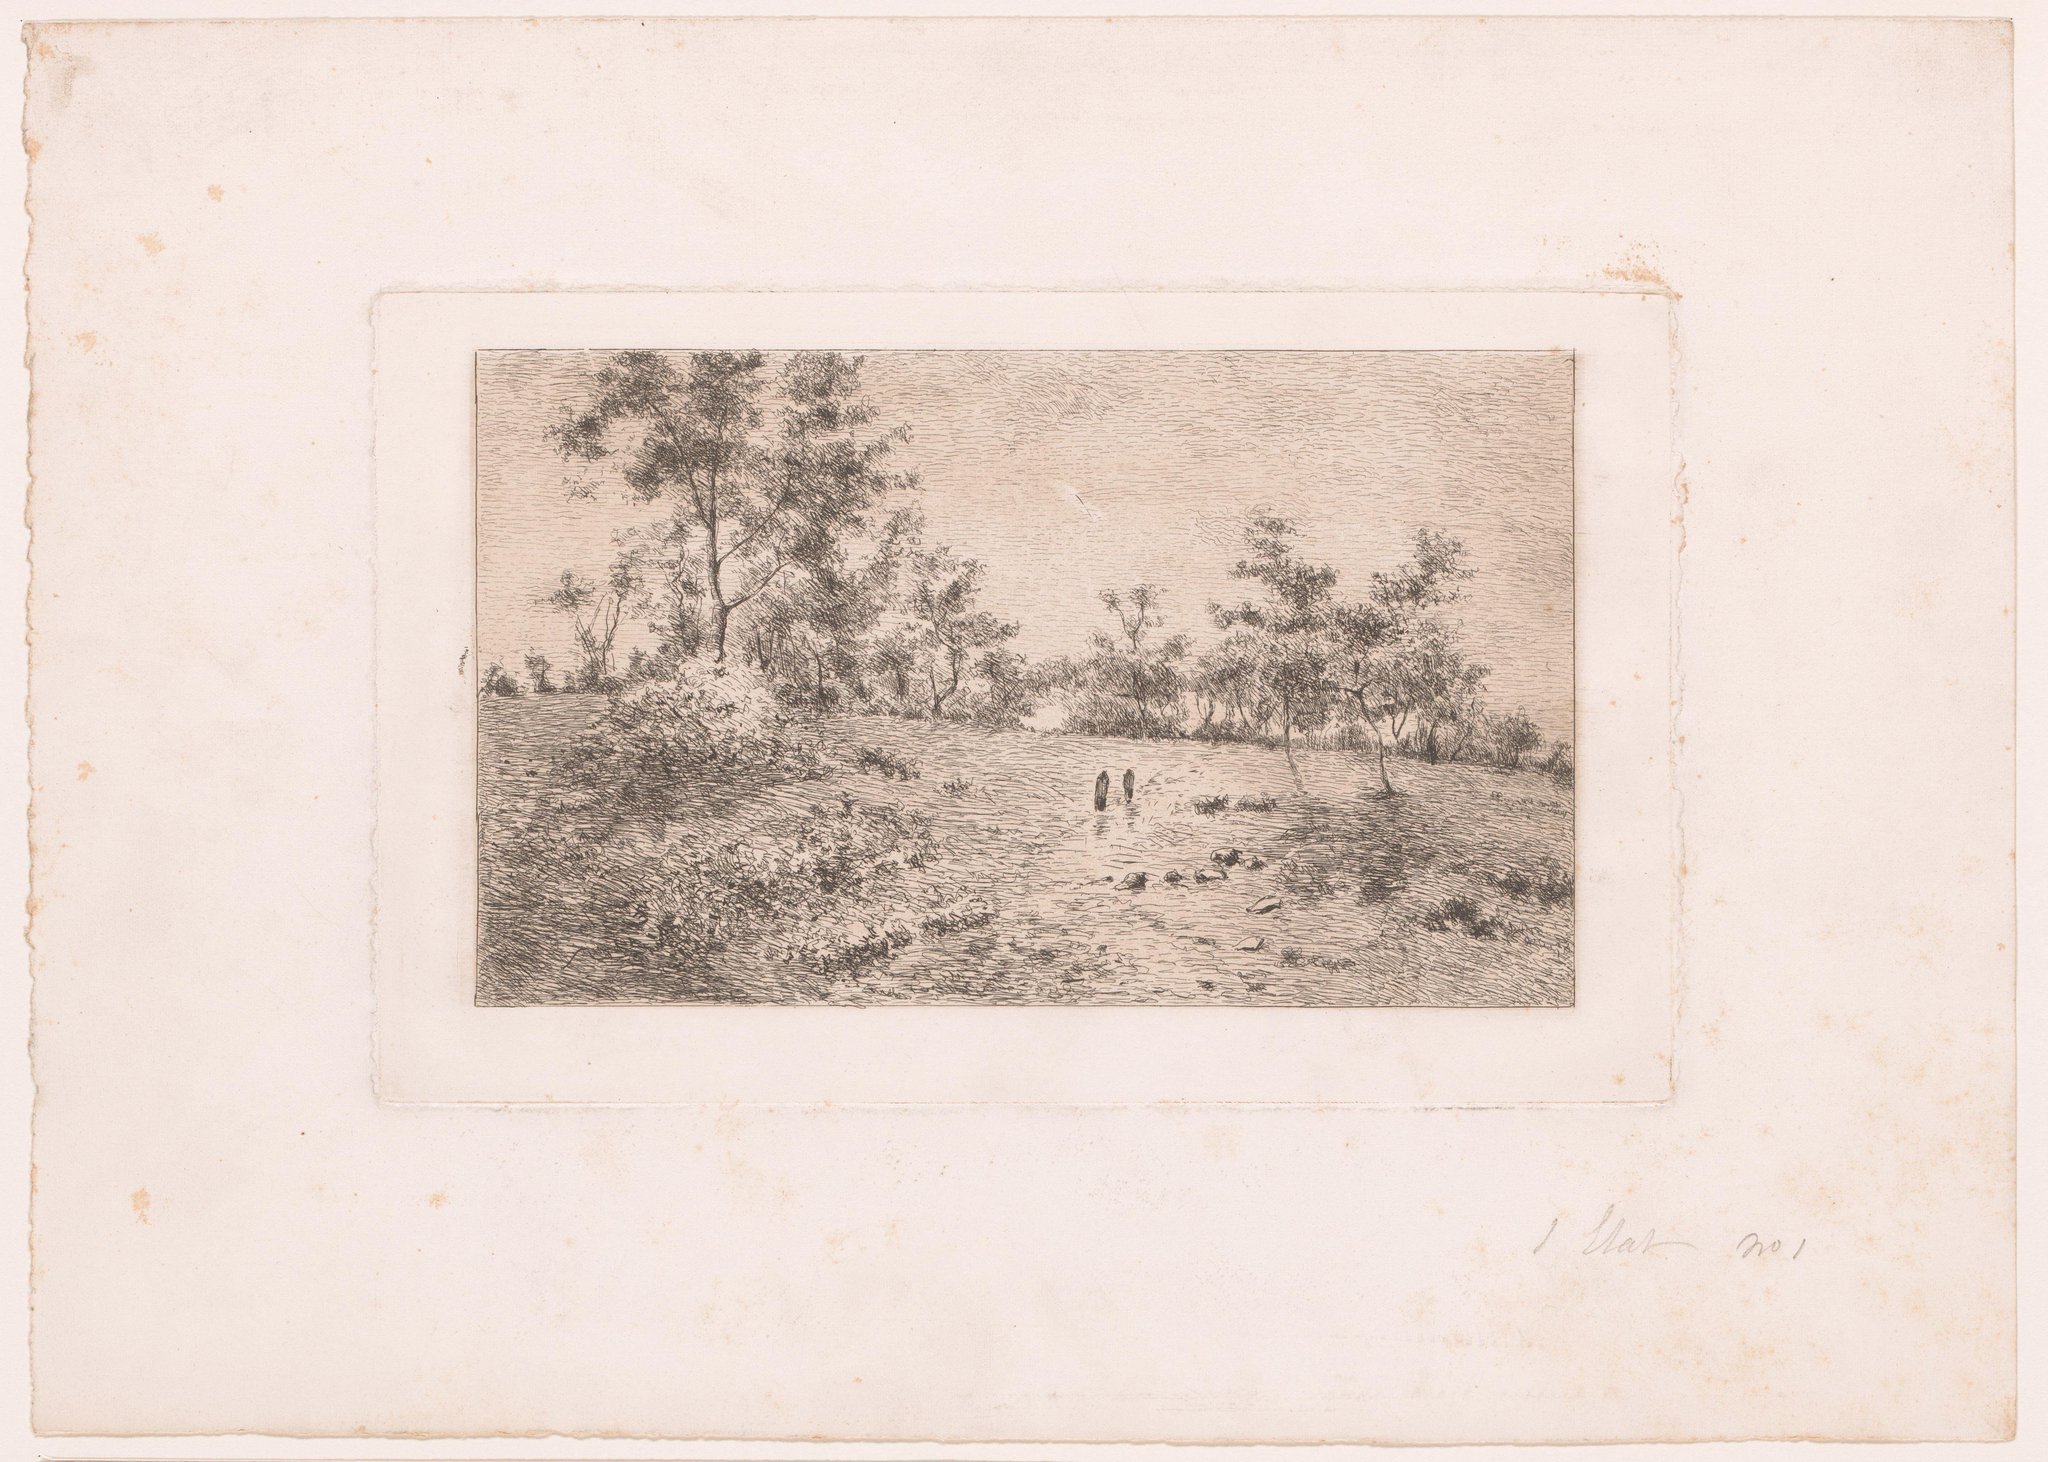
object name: print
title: Landschap met twee wandelaars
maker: jules guiette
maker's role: print maker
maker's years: 1852-1901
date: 1862-1901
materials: paper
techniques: etching, intaglio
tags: landscapes in the temperate zone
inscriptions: collector's mark: Lugt 2228, annotation: ‘1 Etat no 1’